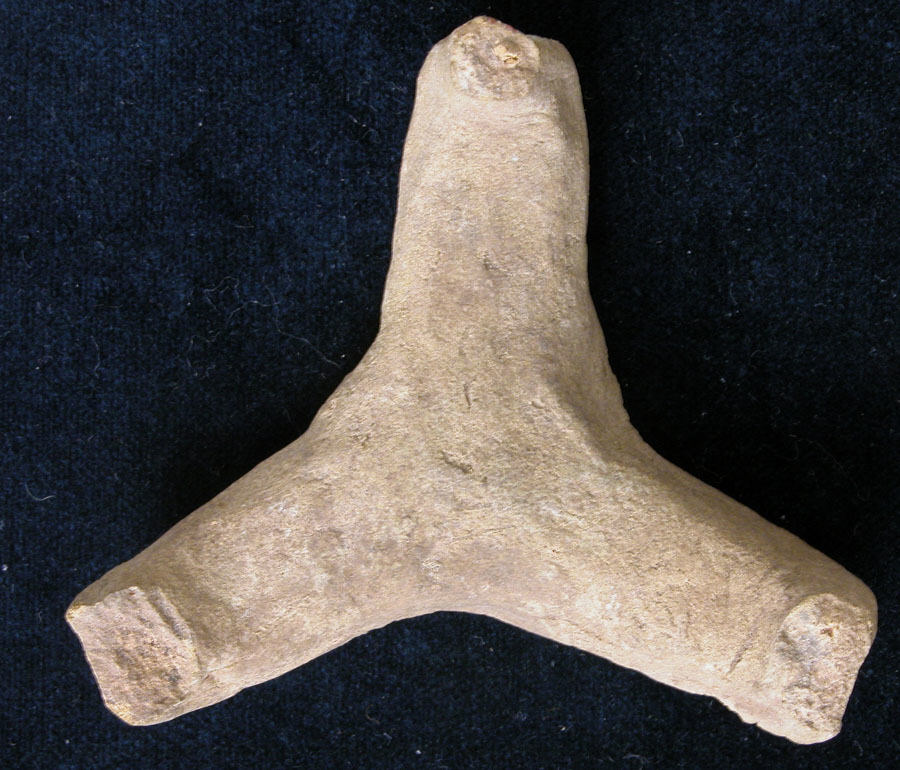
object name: tripod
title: Tripod for kiln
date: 1101-1500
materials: earthenware, glaze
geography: egypt